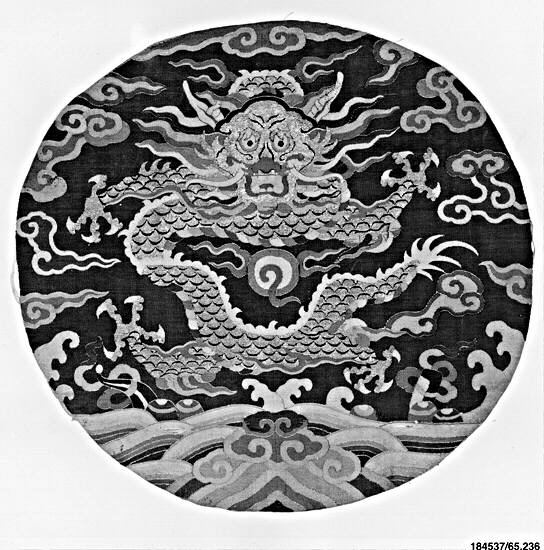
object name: roundel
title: Roundel with Four-Clawed Dragon (Mang)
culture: chinese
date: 1701-1800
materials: gold thread, silk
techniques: tapestry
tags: dragons